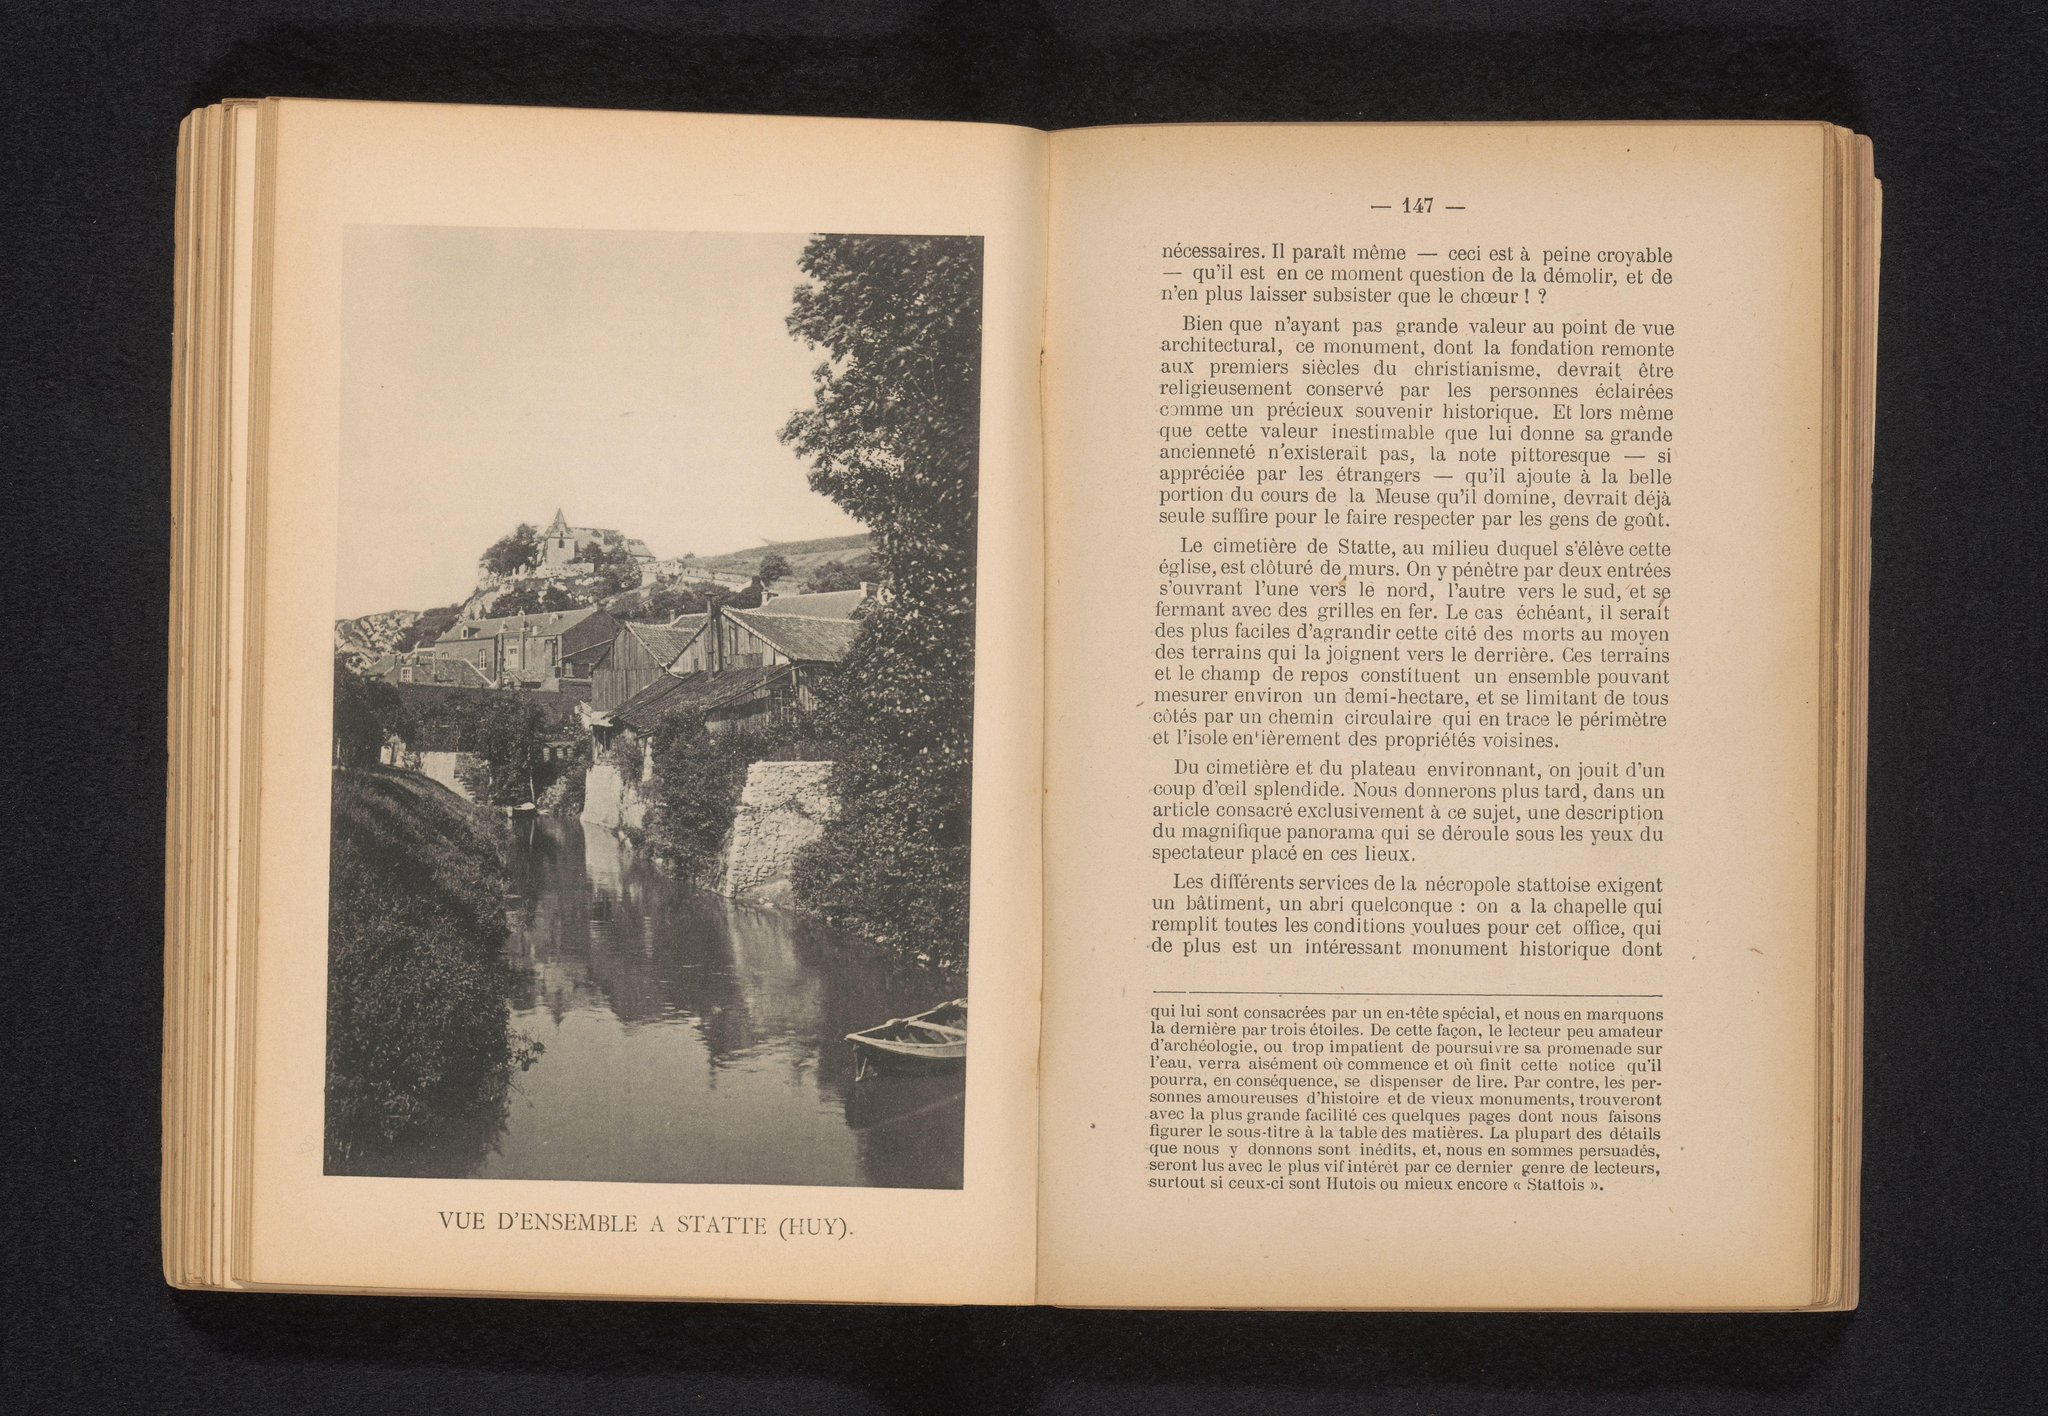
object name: page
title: Gezicht op Hoei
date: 1885-1890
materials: paper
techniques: photograph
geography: hoei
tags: city-view in general; 'veduta'